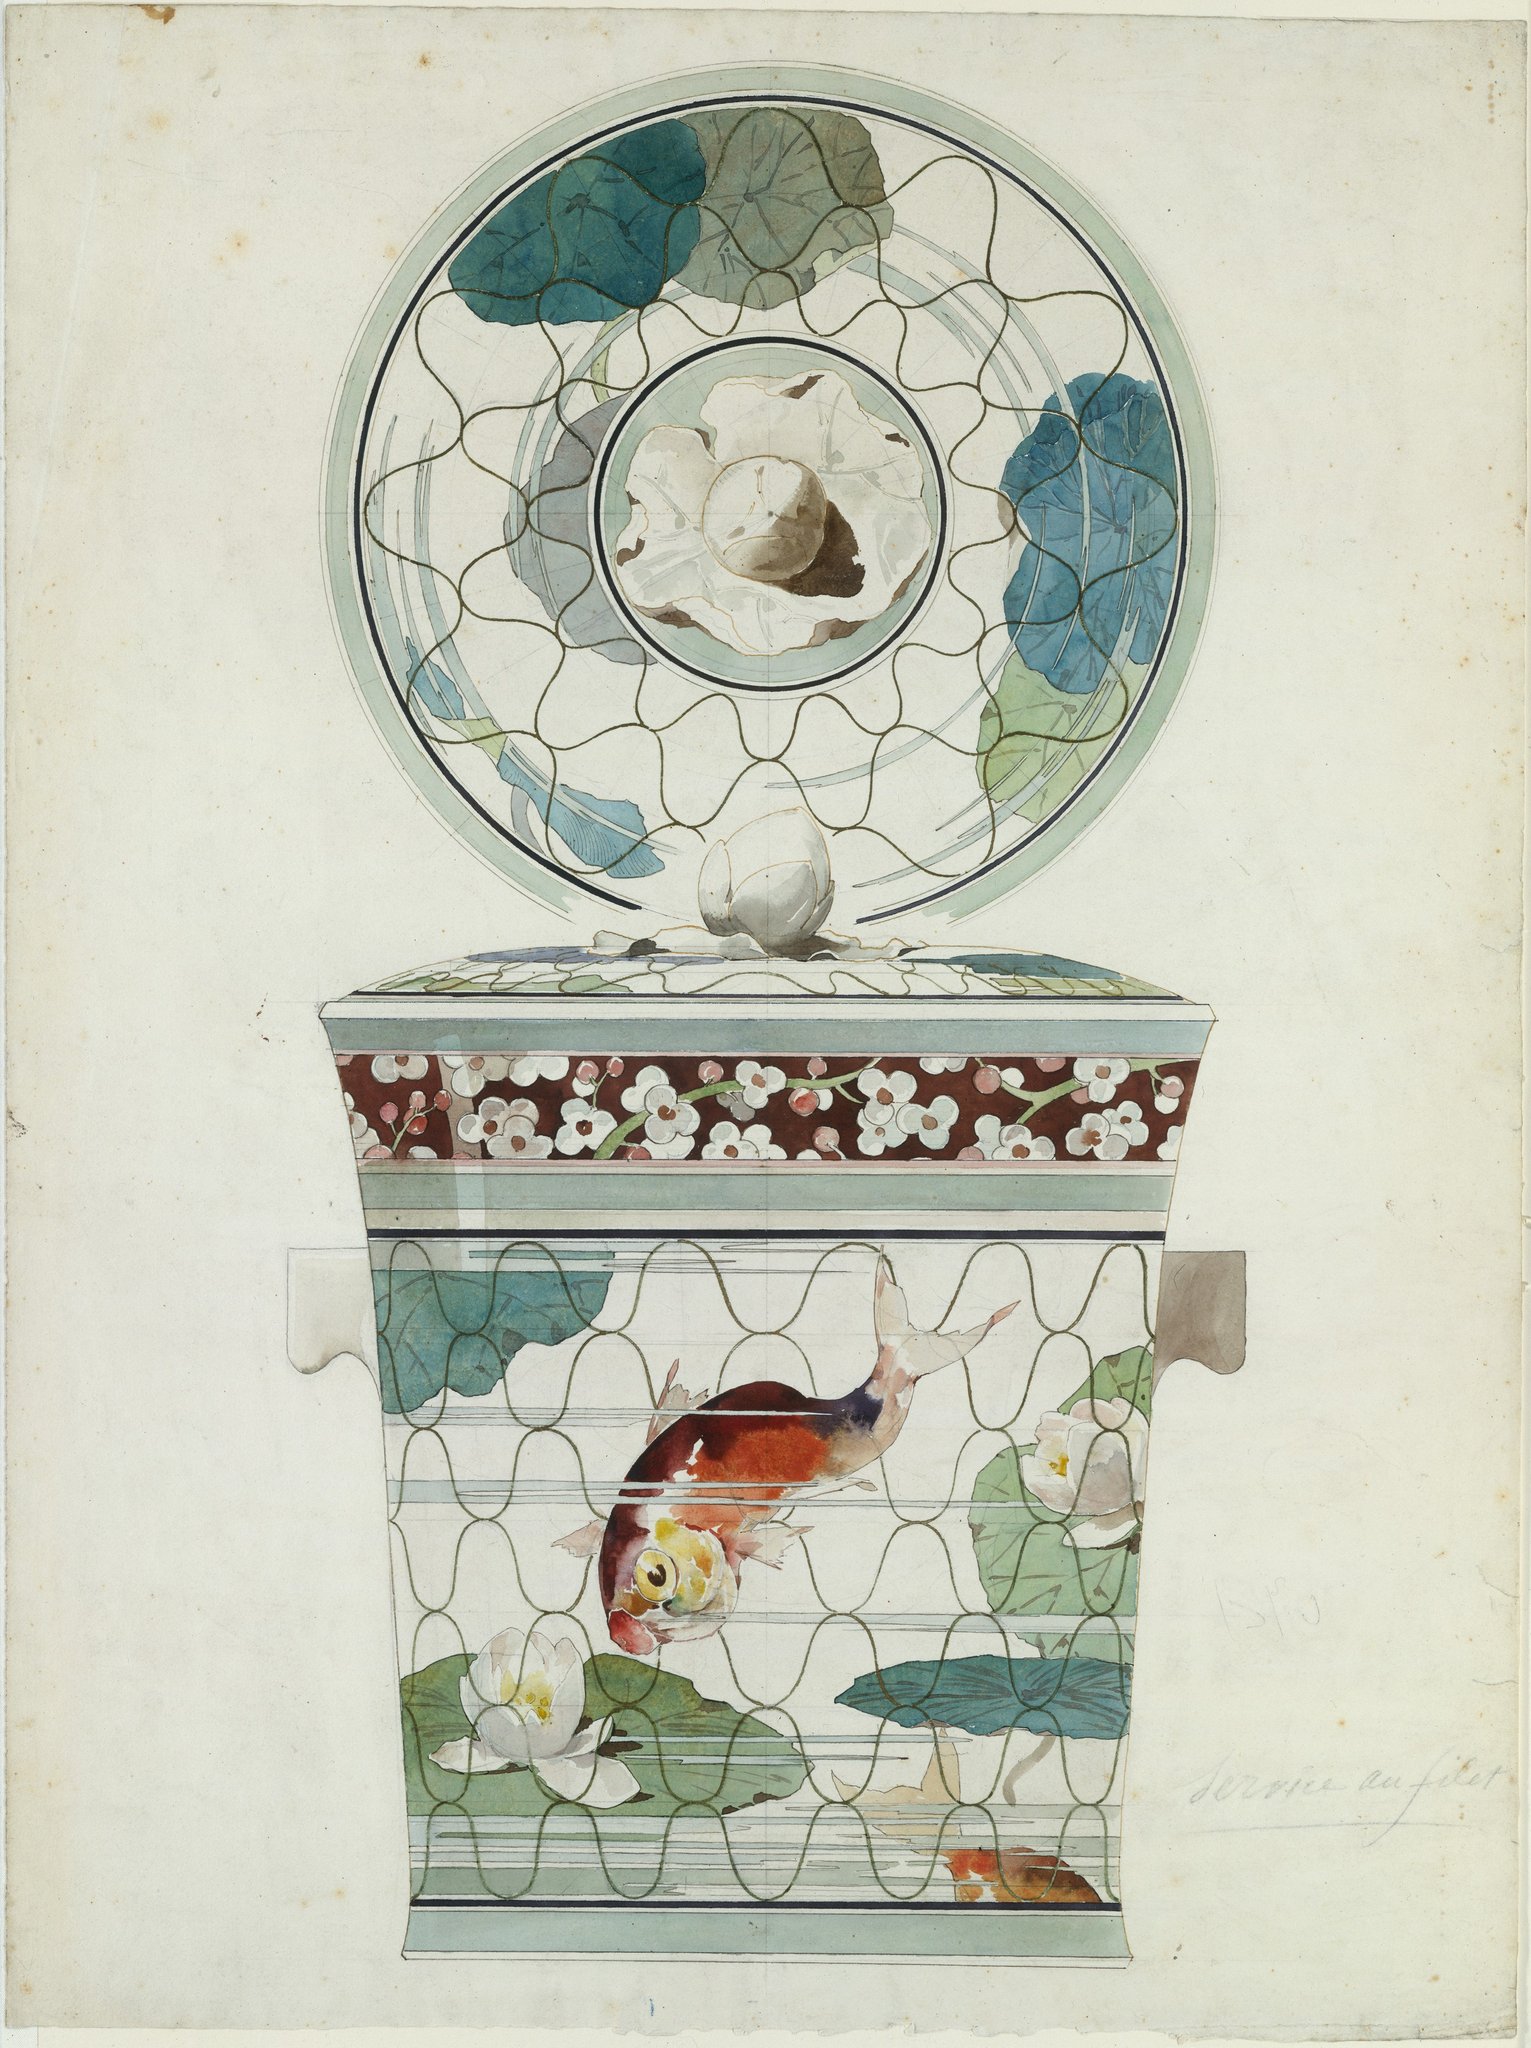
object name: drawing ornament architecture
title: Design for a Covered Dish in the "Service au Filet" (Fish Net Ware), Maison J. Vieillard et Cie, Bordeaux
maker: amédée de caranza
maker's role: artist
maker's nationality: french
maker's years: 1843-1914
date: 1875-1885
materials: gold paint, graphite, ink, watercolor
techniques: pen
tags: fish,flowers,dishes